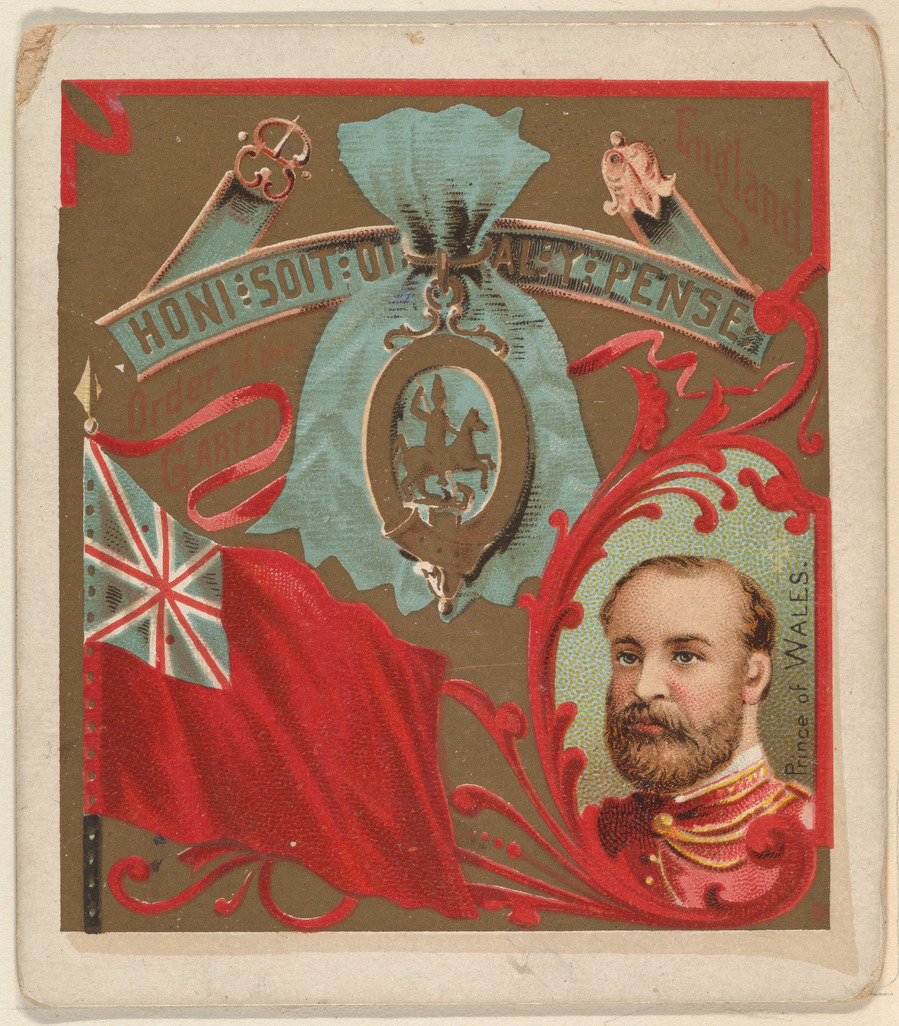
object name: print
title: England, from the International Cards series (N238), issued by Kinney Bros.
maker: kinney brothers tobacco company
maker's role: publisher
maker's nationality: american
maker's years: 1869-2011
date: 1888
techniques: color lithograph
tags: men,coat of arms,flags